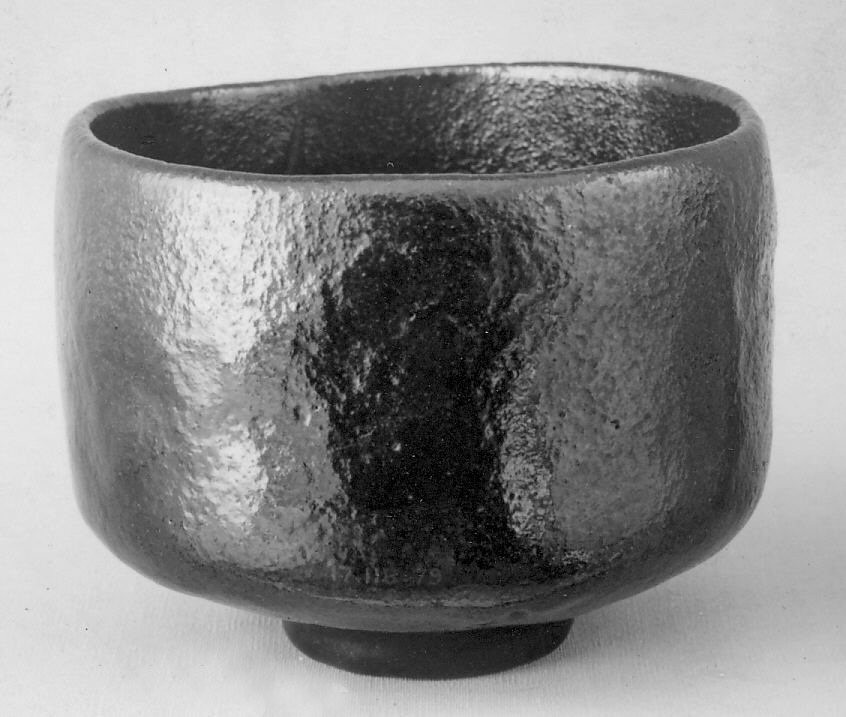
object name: teabowl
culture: japanese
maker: ichinyu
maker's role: artist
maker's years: 1582-1682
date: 1675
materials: clay, glaze